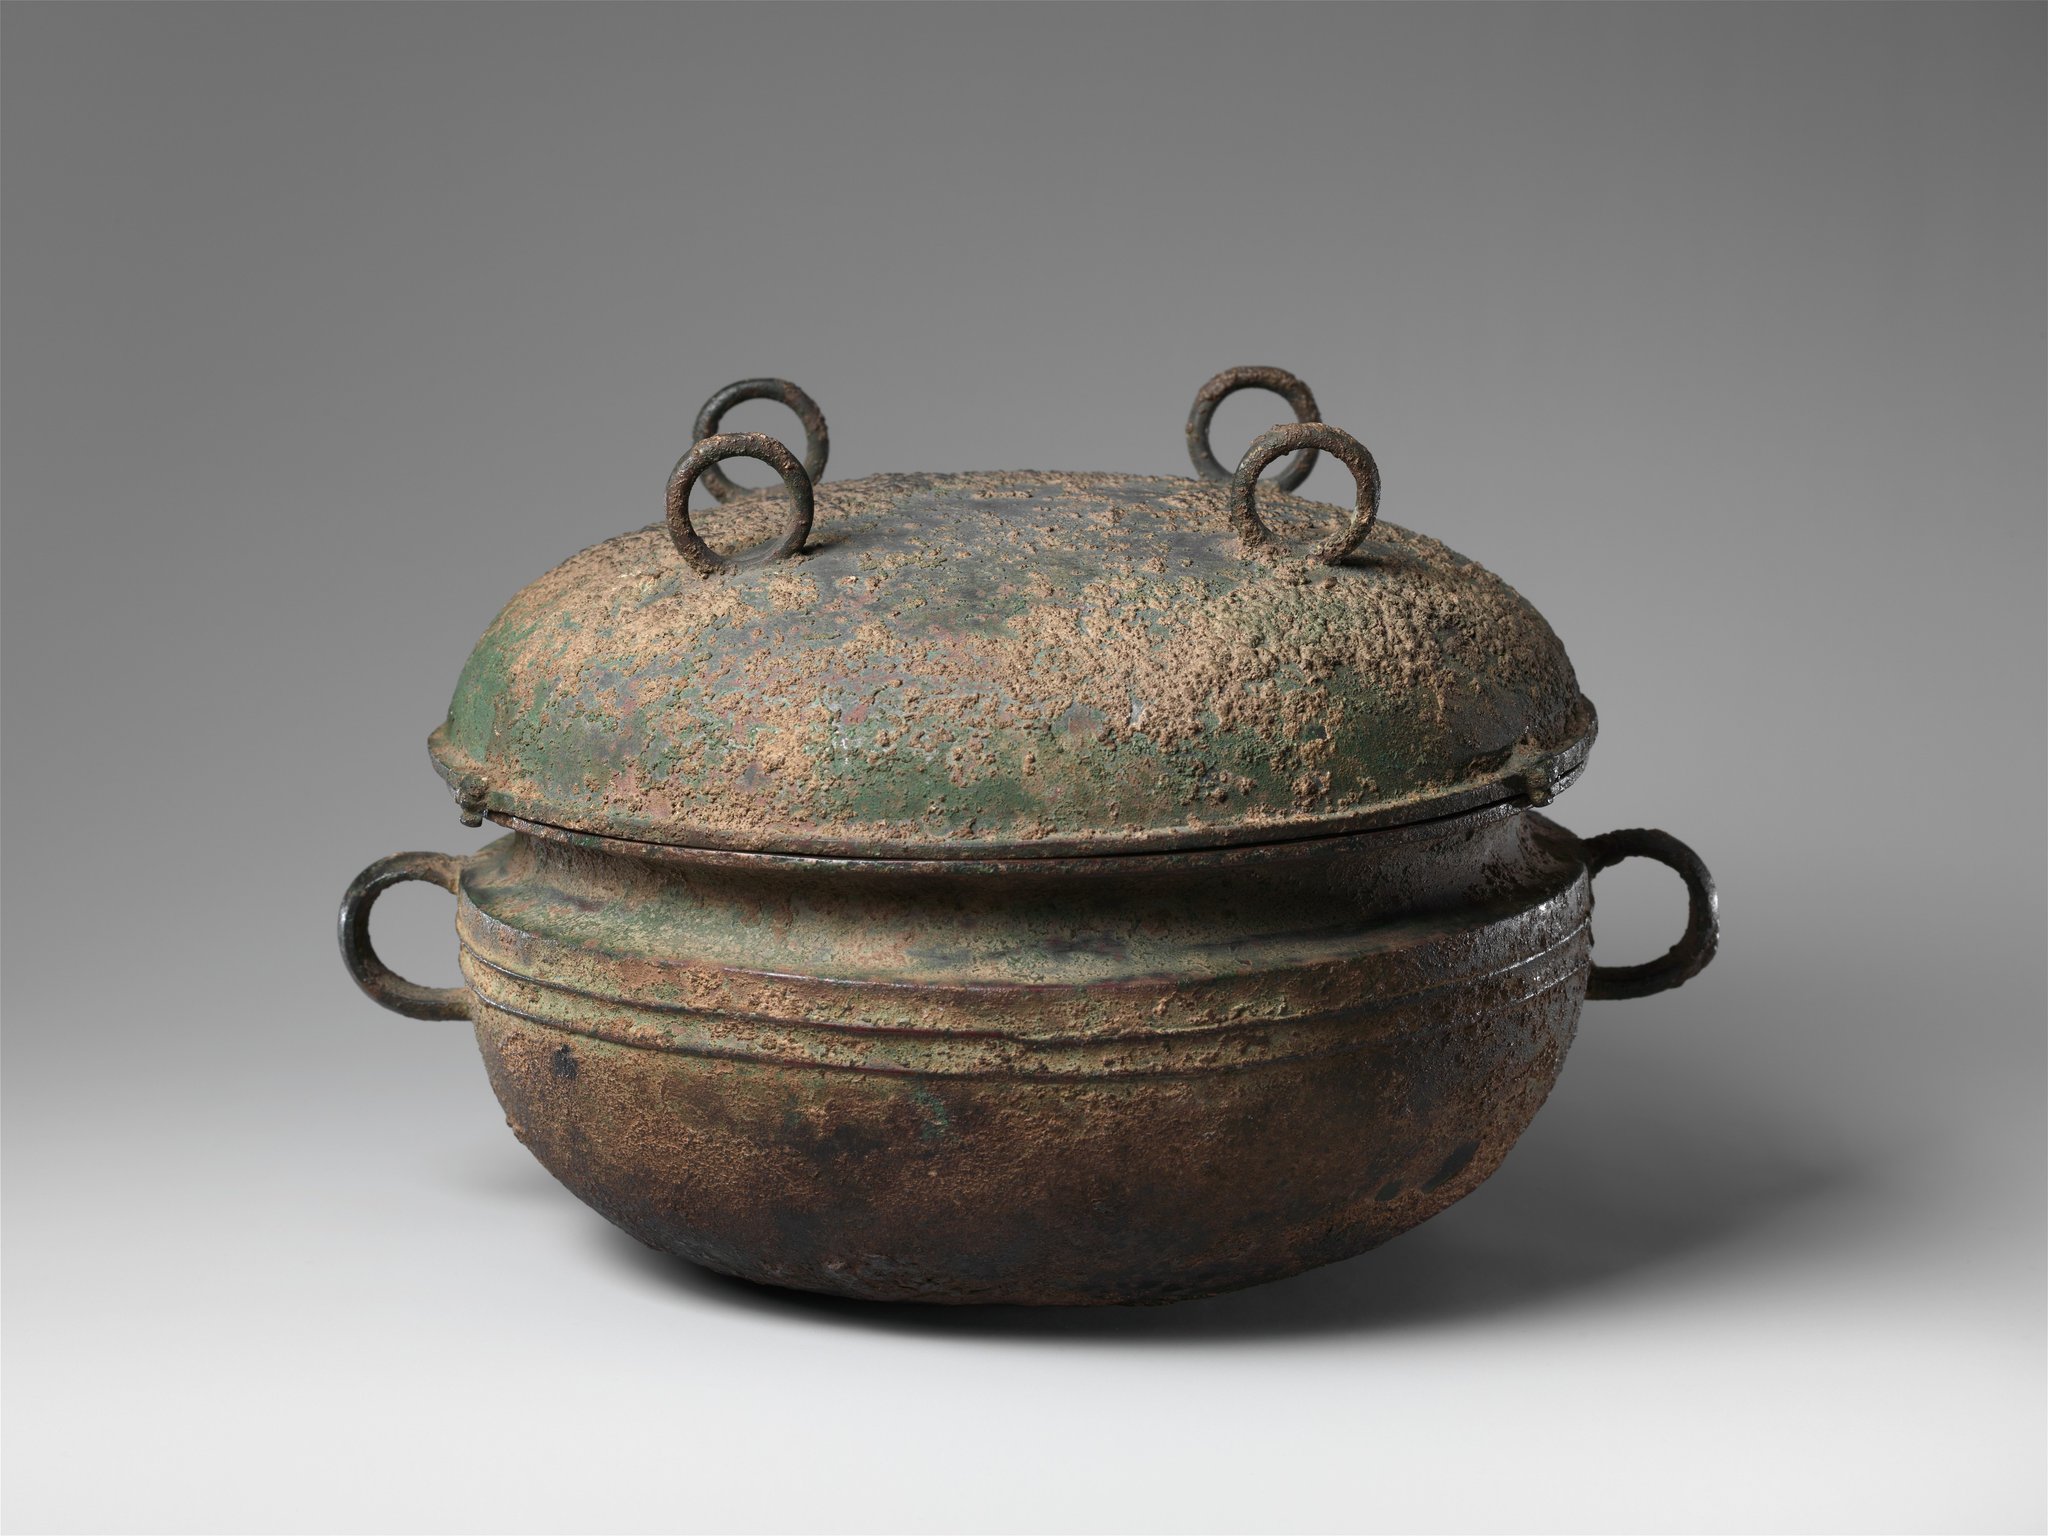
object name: covered food vessel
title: Covered Food Vessel (Qi hou dun)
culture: chinese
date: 770-255 BCE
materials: bronze